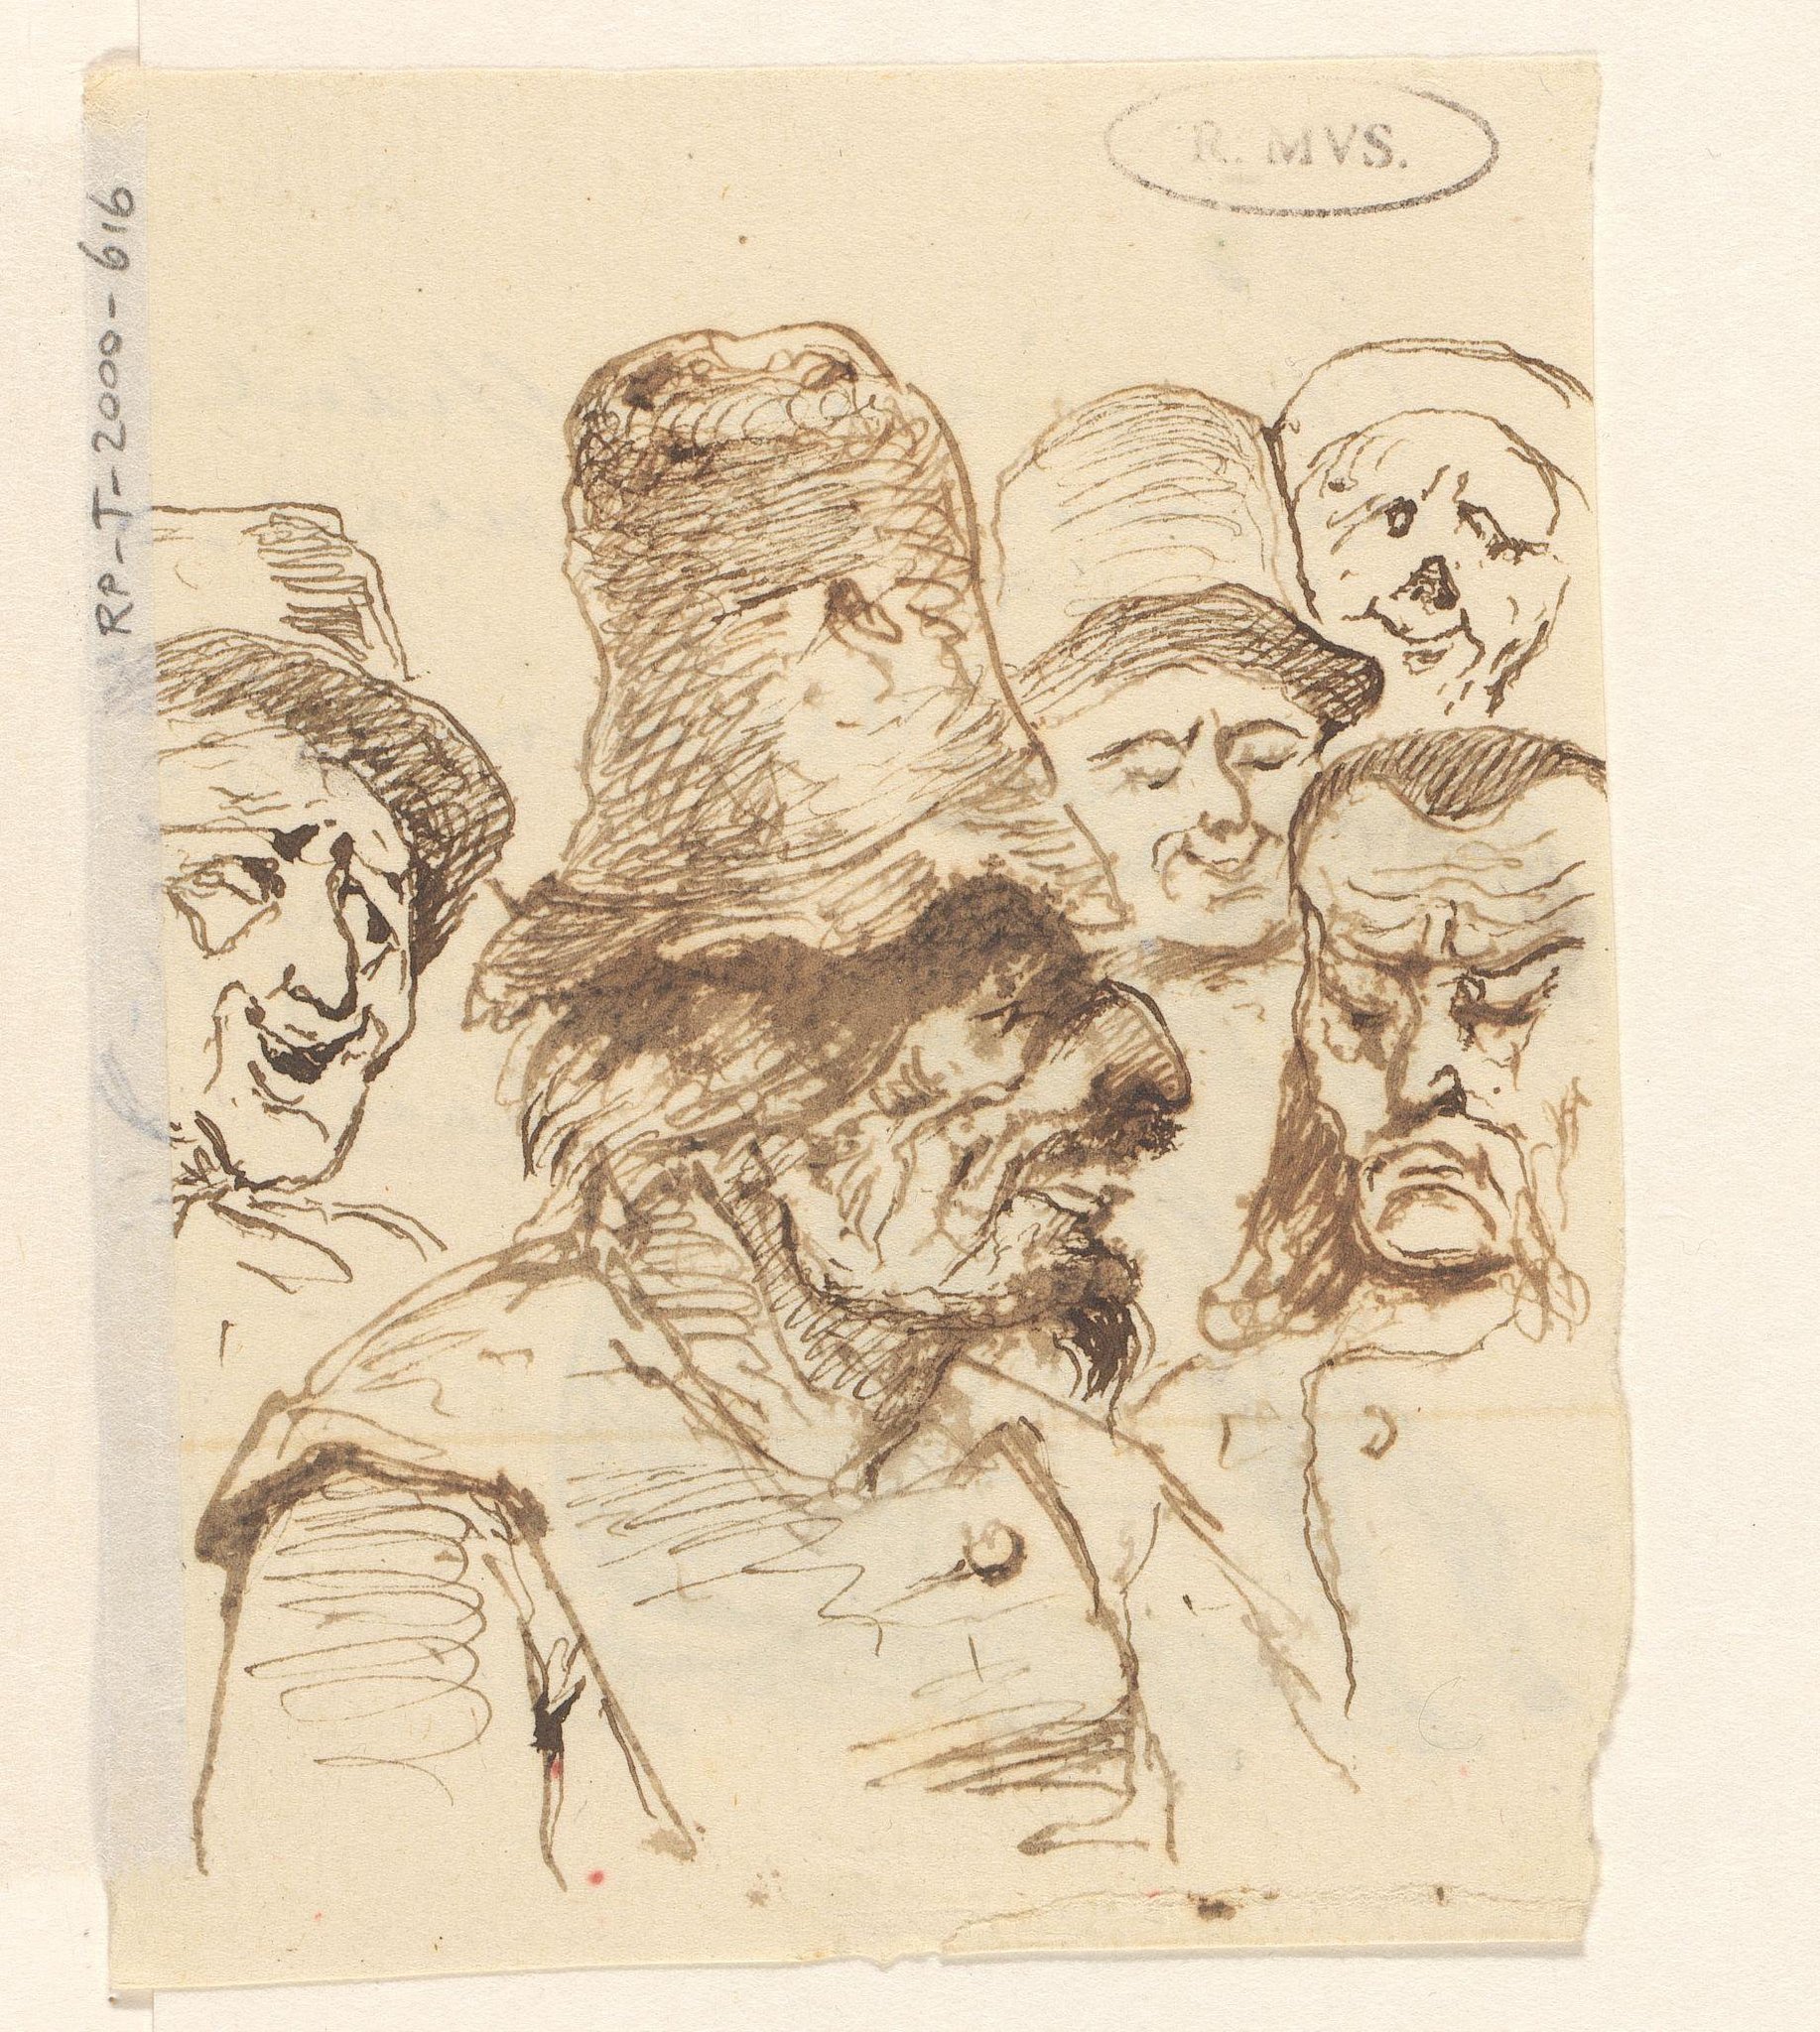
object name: drawing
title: Een zich verontschuldigende strooper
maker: johannes tavenraat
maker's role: draughtsman, painter, print maker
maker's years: 1809-1881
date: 1840-1880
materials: ink, paper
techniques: pen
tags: poacher, caricatures (human types)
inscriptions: collector's mark: Lugt 2228, annotation: ‘Een zich verontschuldigende strooper / Een zwaar gekwetste haas’, signature: ‘Tavenraat’